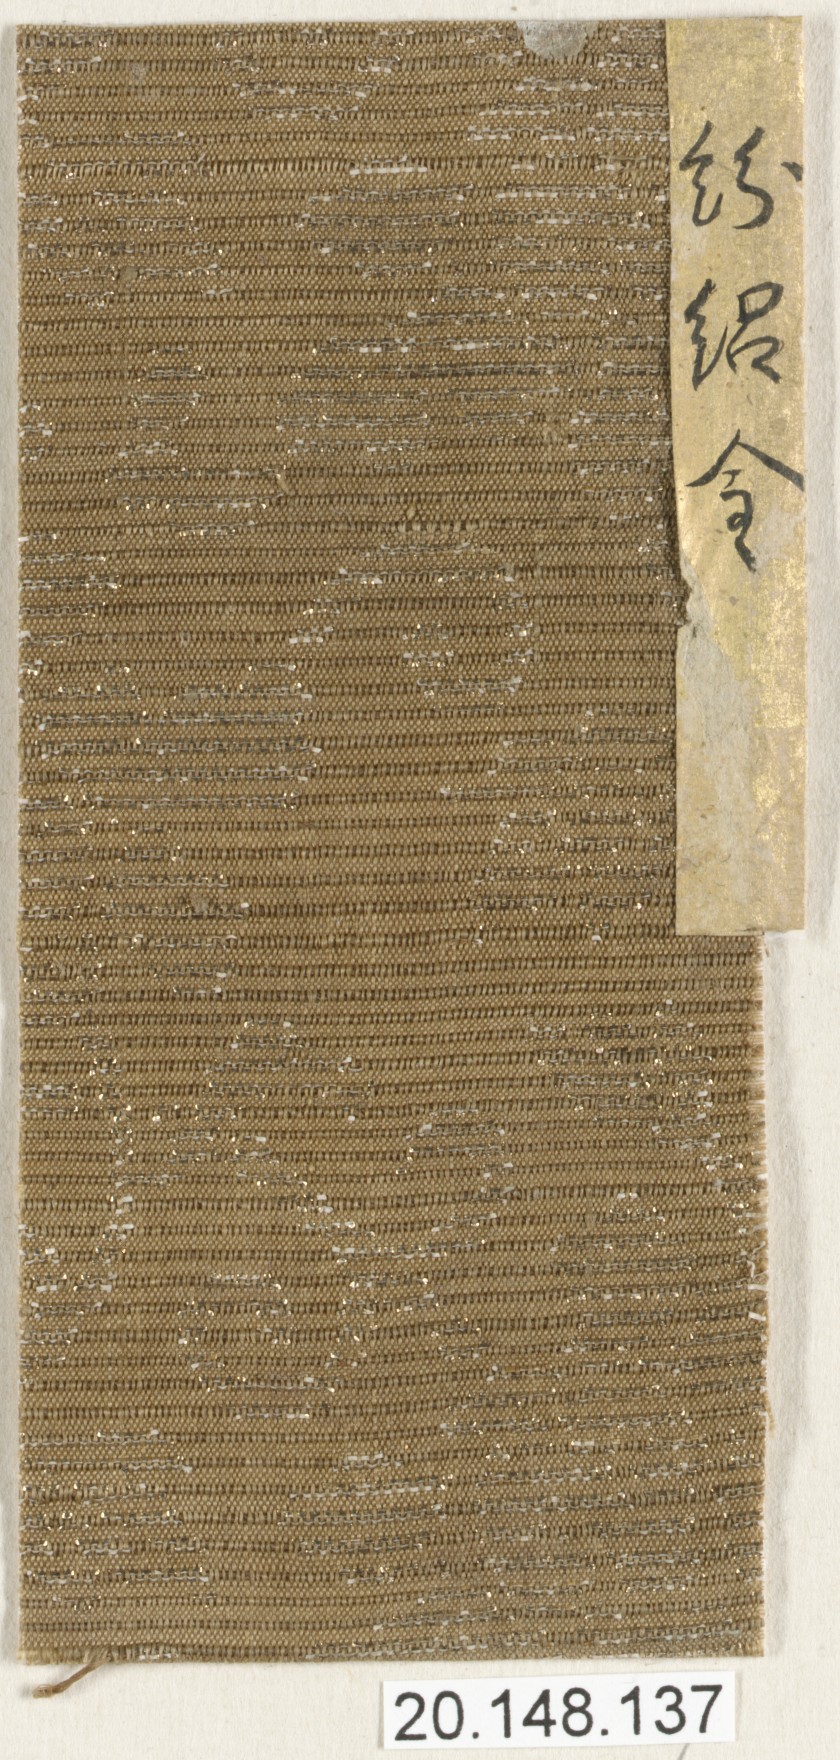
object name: piece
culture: japanese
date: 1401-1500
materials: silk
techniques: compound weave